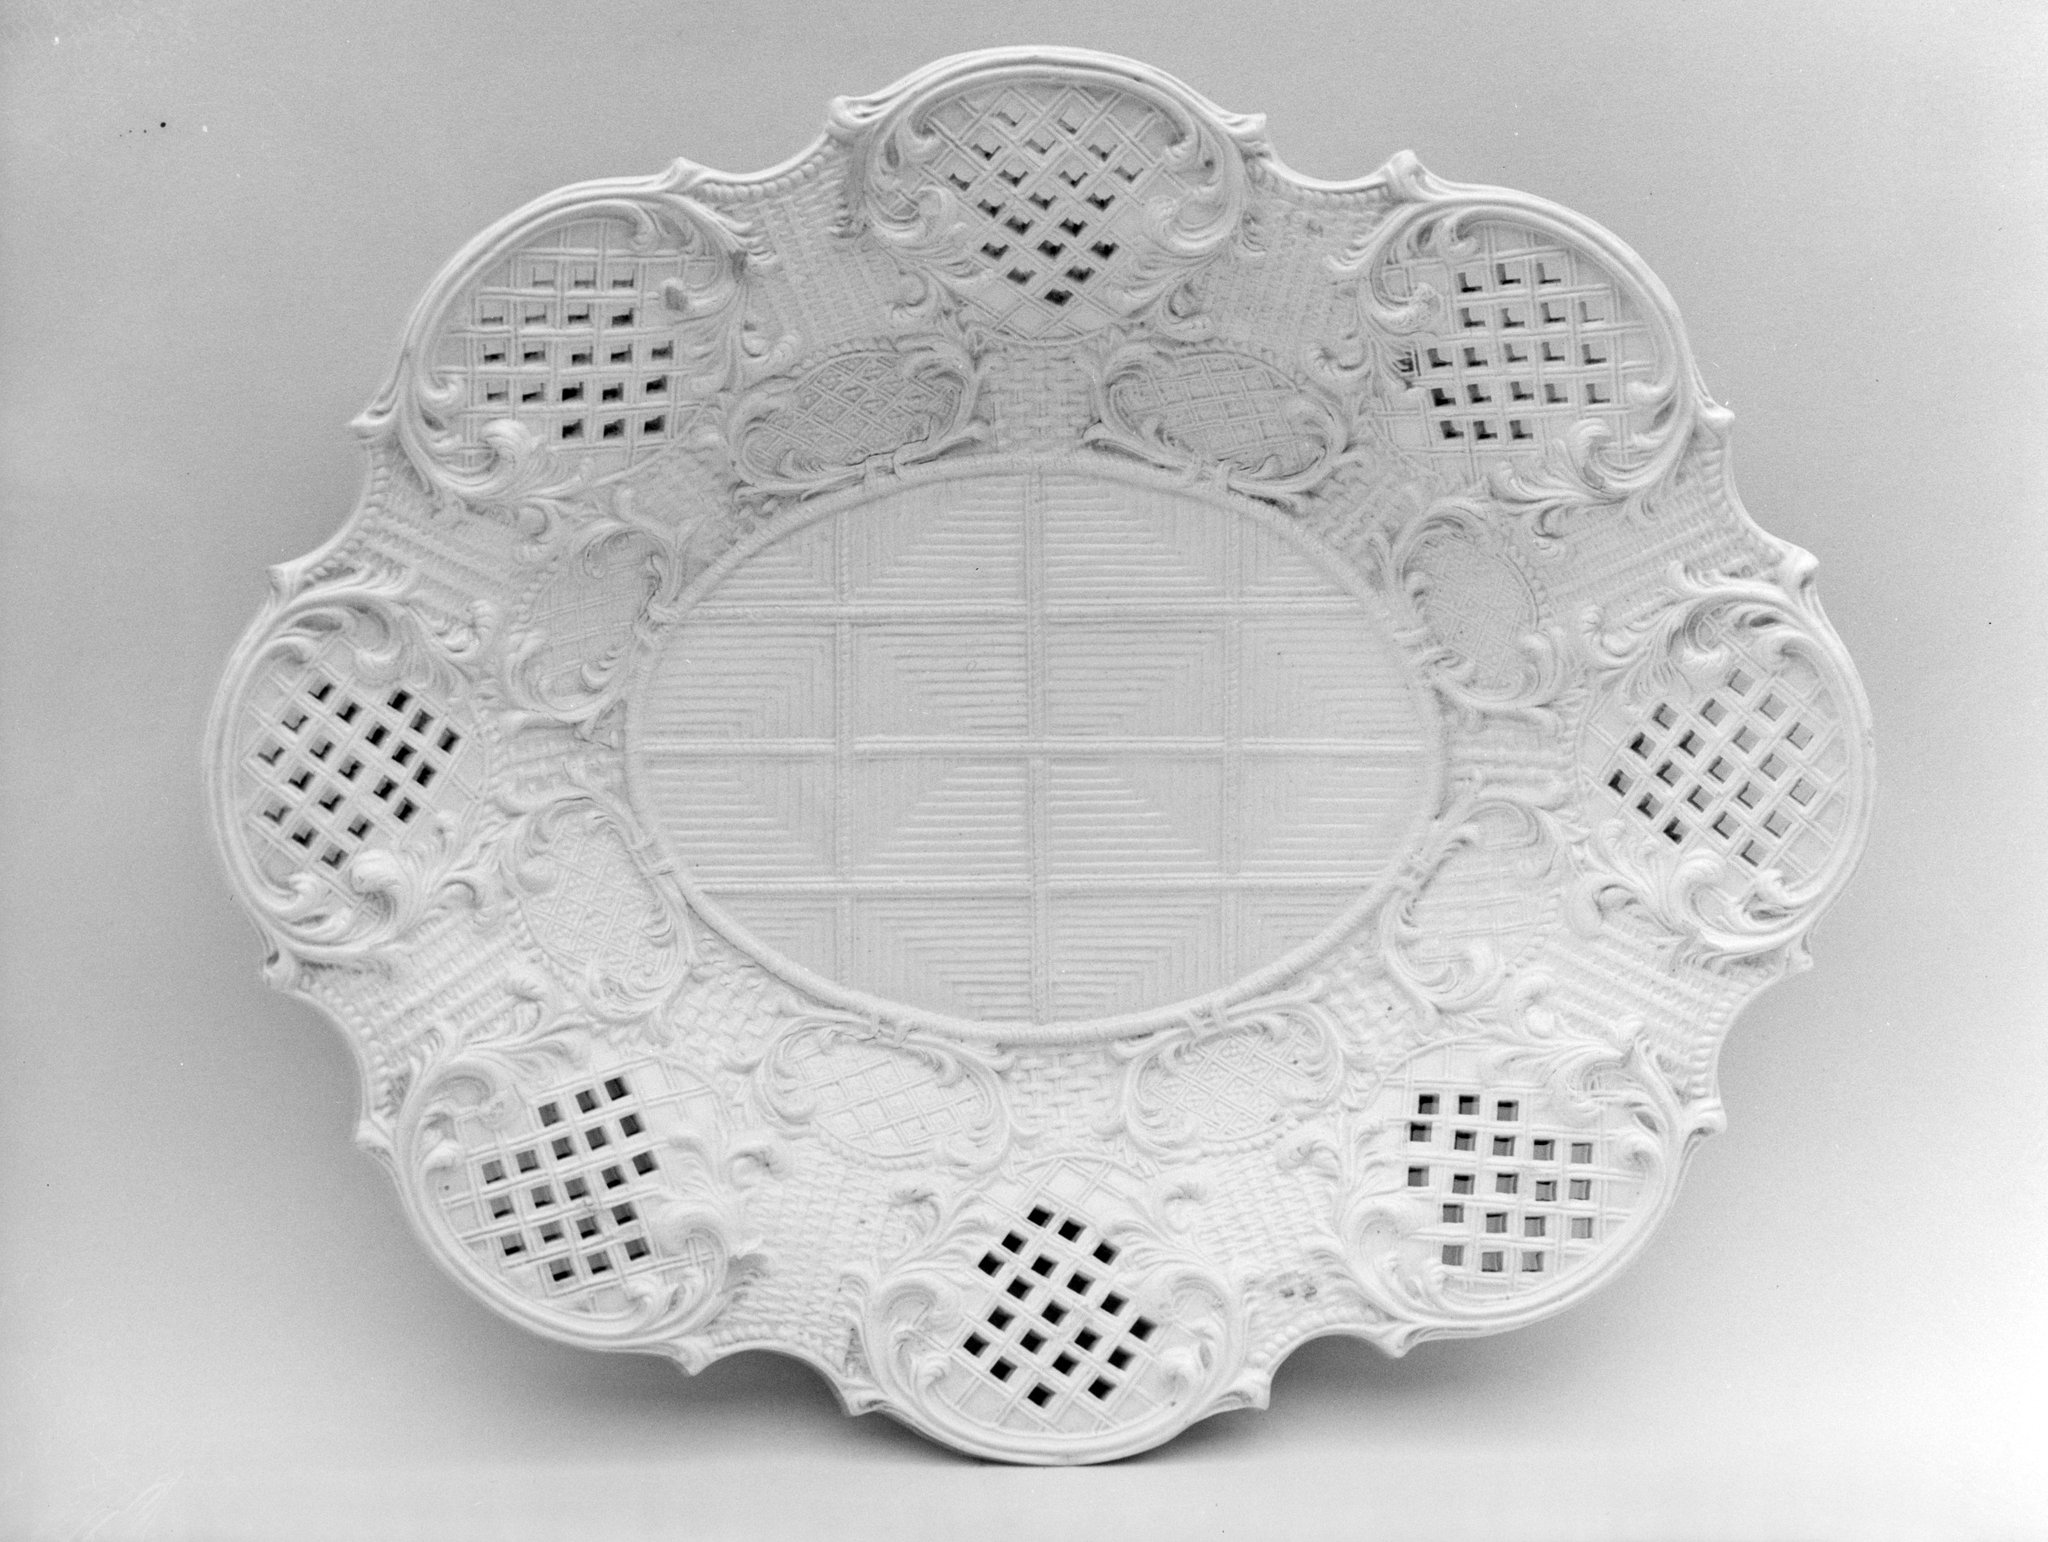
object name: plate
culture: british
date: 1740-1760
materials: stoneware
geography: england